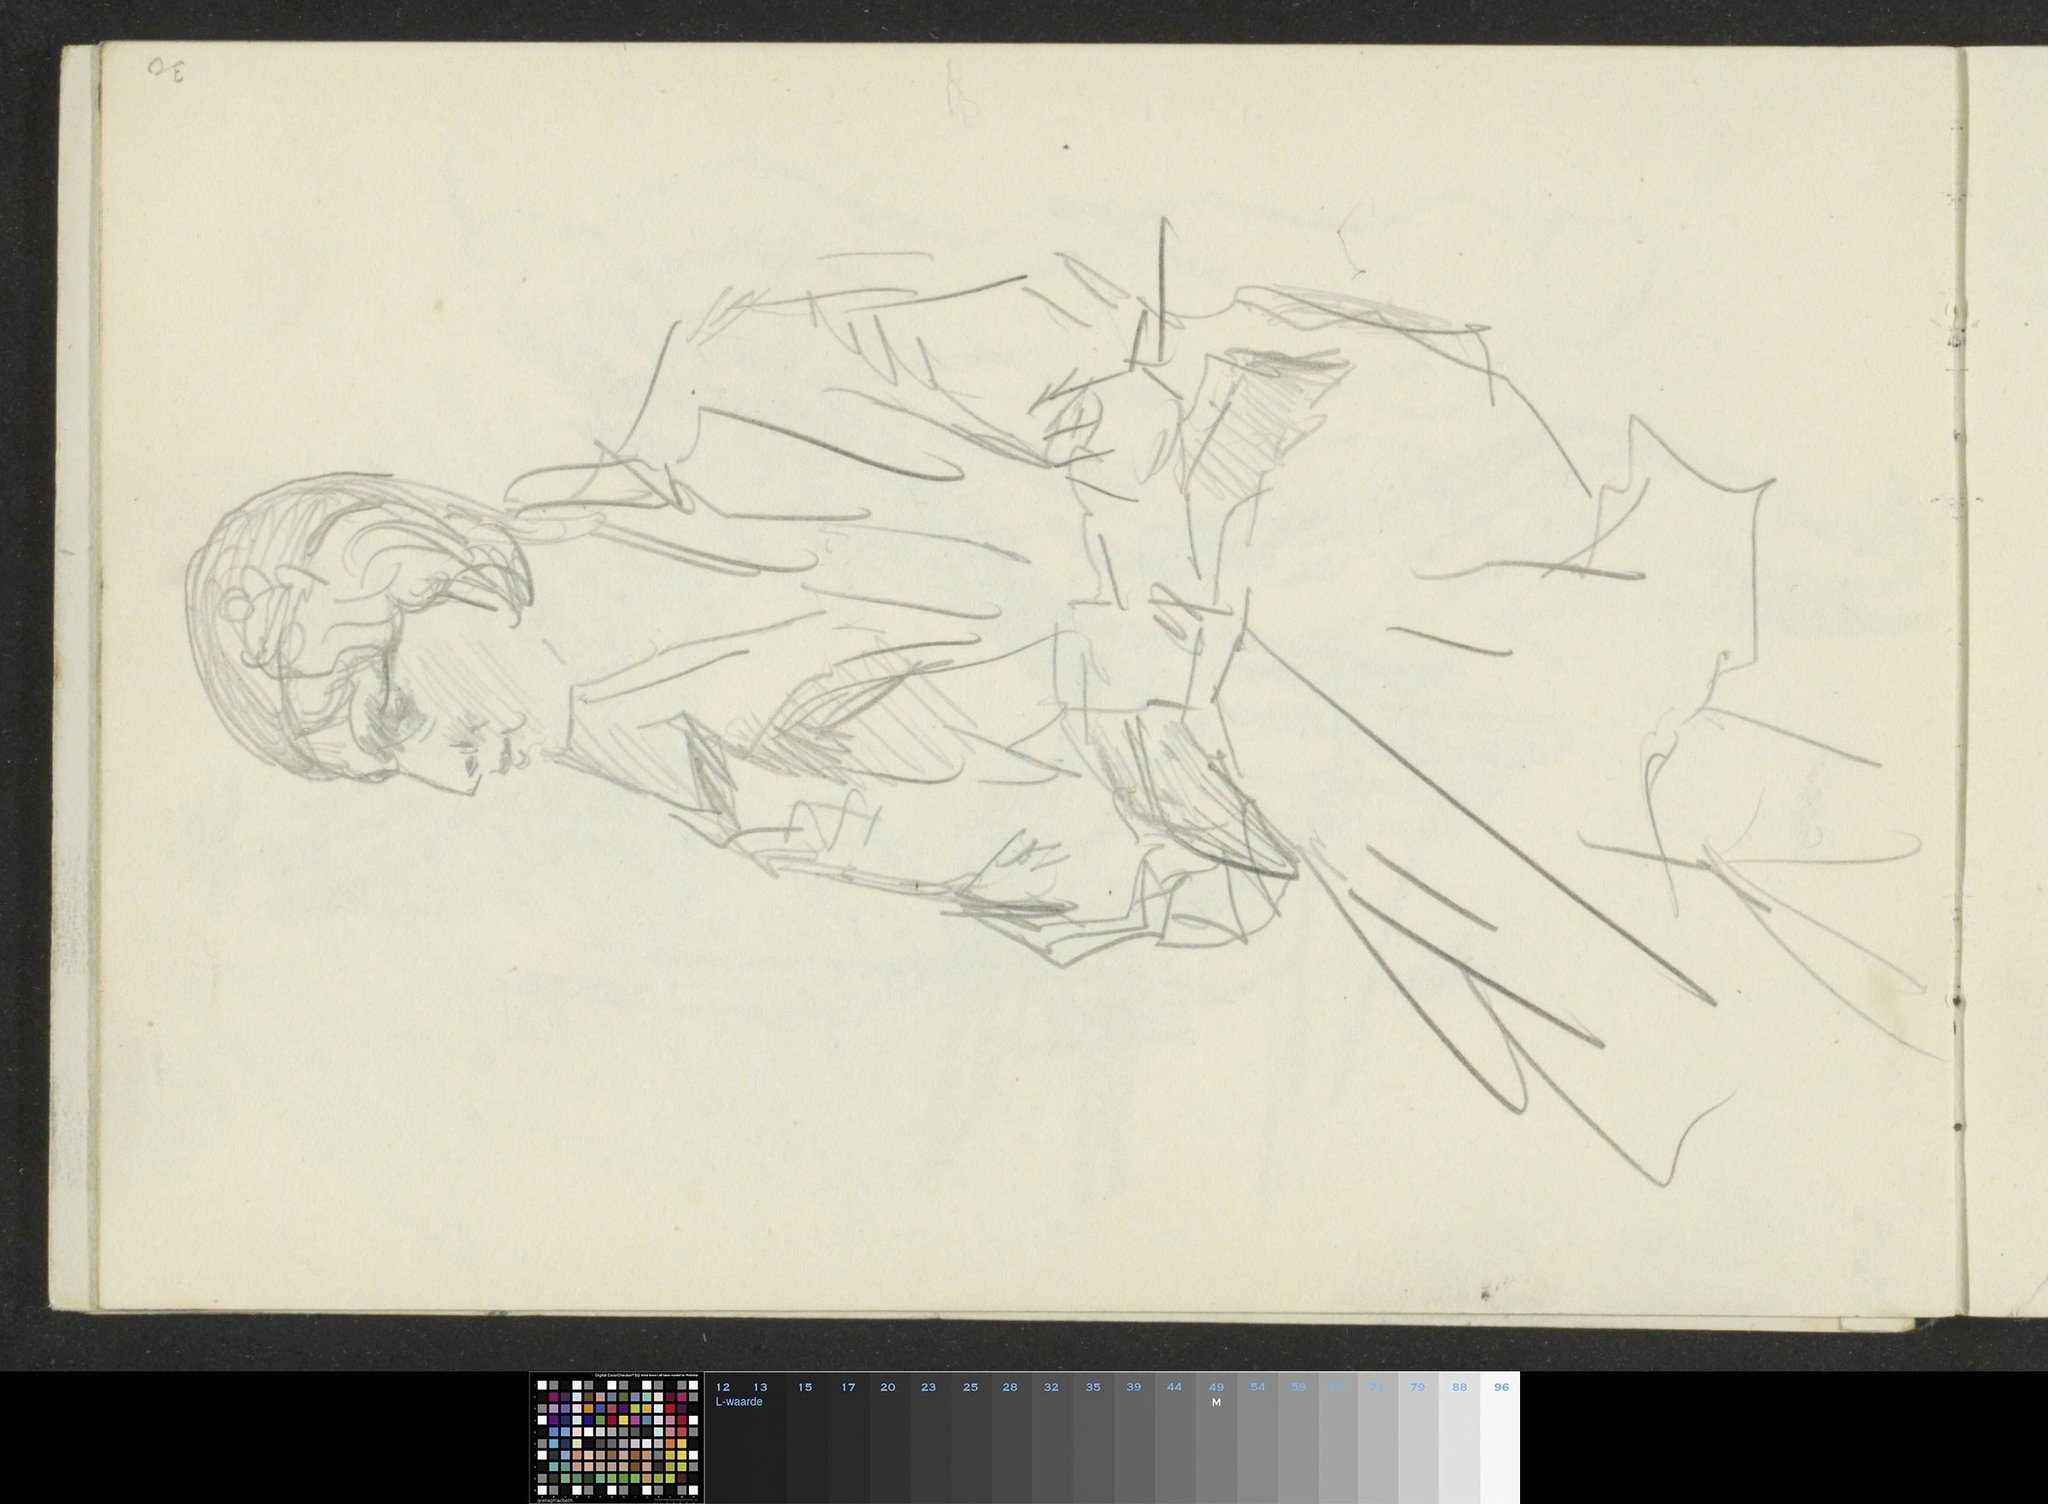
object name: sketchbook leaf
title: Zittende vrouw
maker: isaac israels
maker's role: draughtsman, painter, print maker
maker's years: 1865-1934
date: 1875-1934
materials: paper, pencil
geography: the hague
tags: adult woman (+ sitting)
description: Mogelijk met hoofddoek. Blad 11 verso uit schetsboek LXI met 20 bladen.